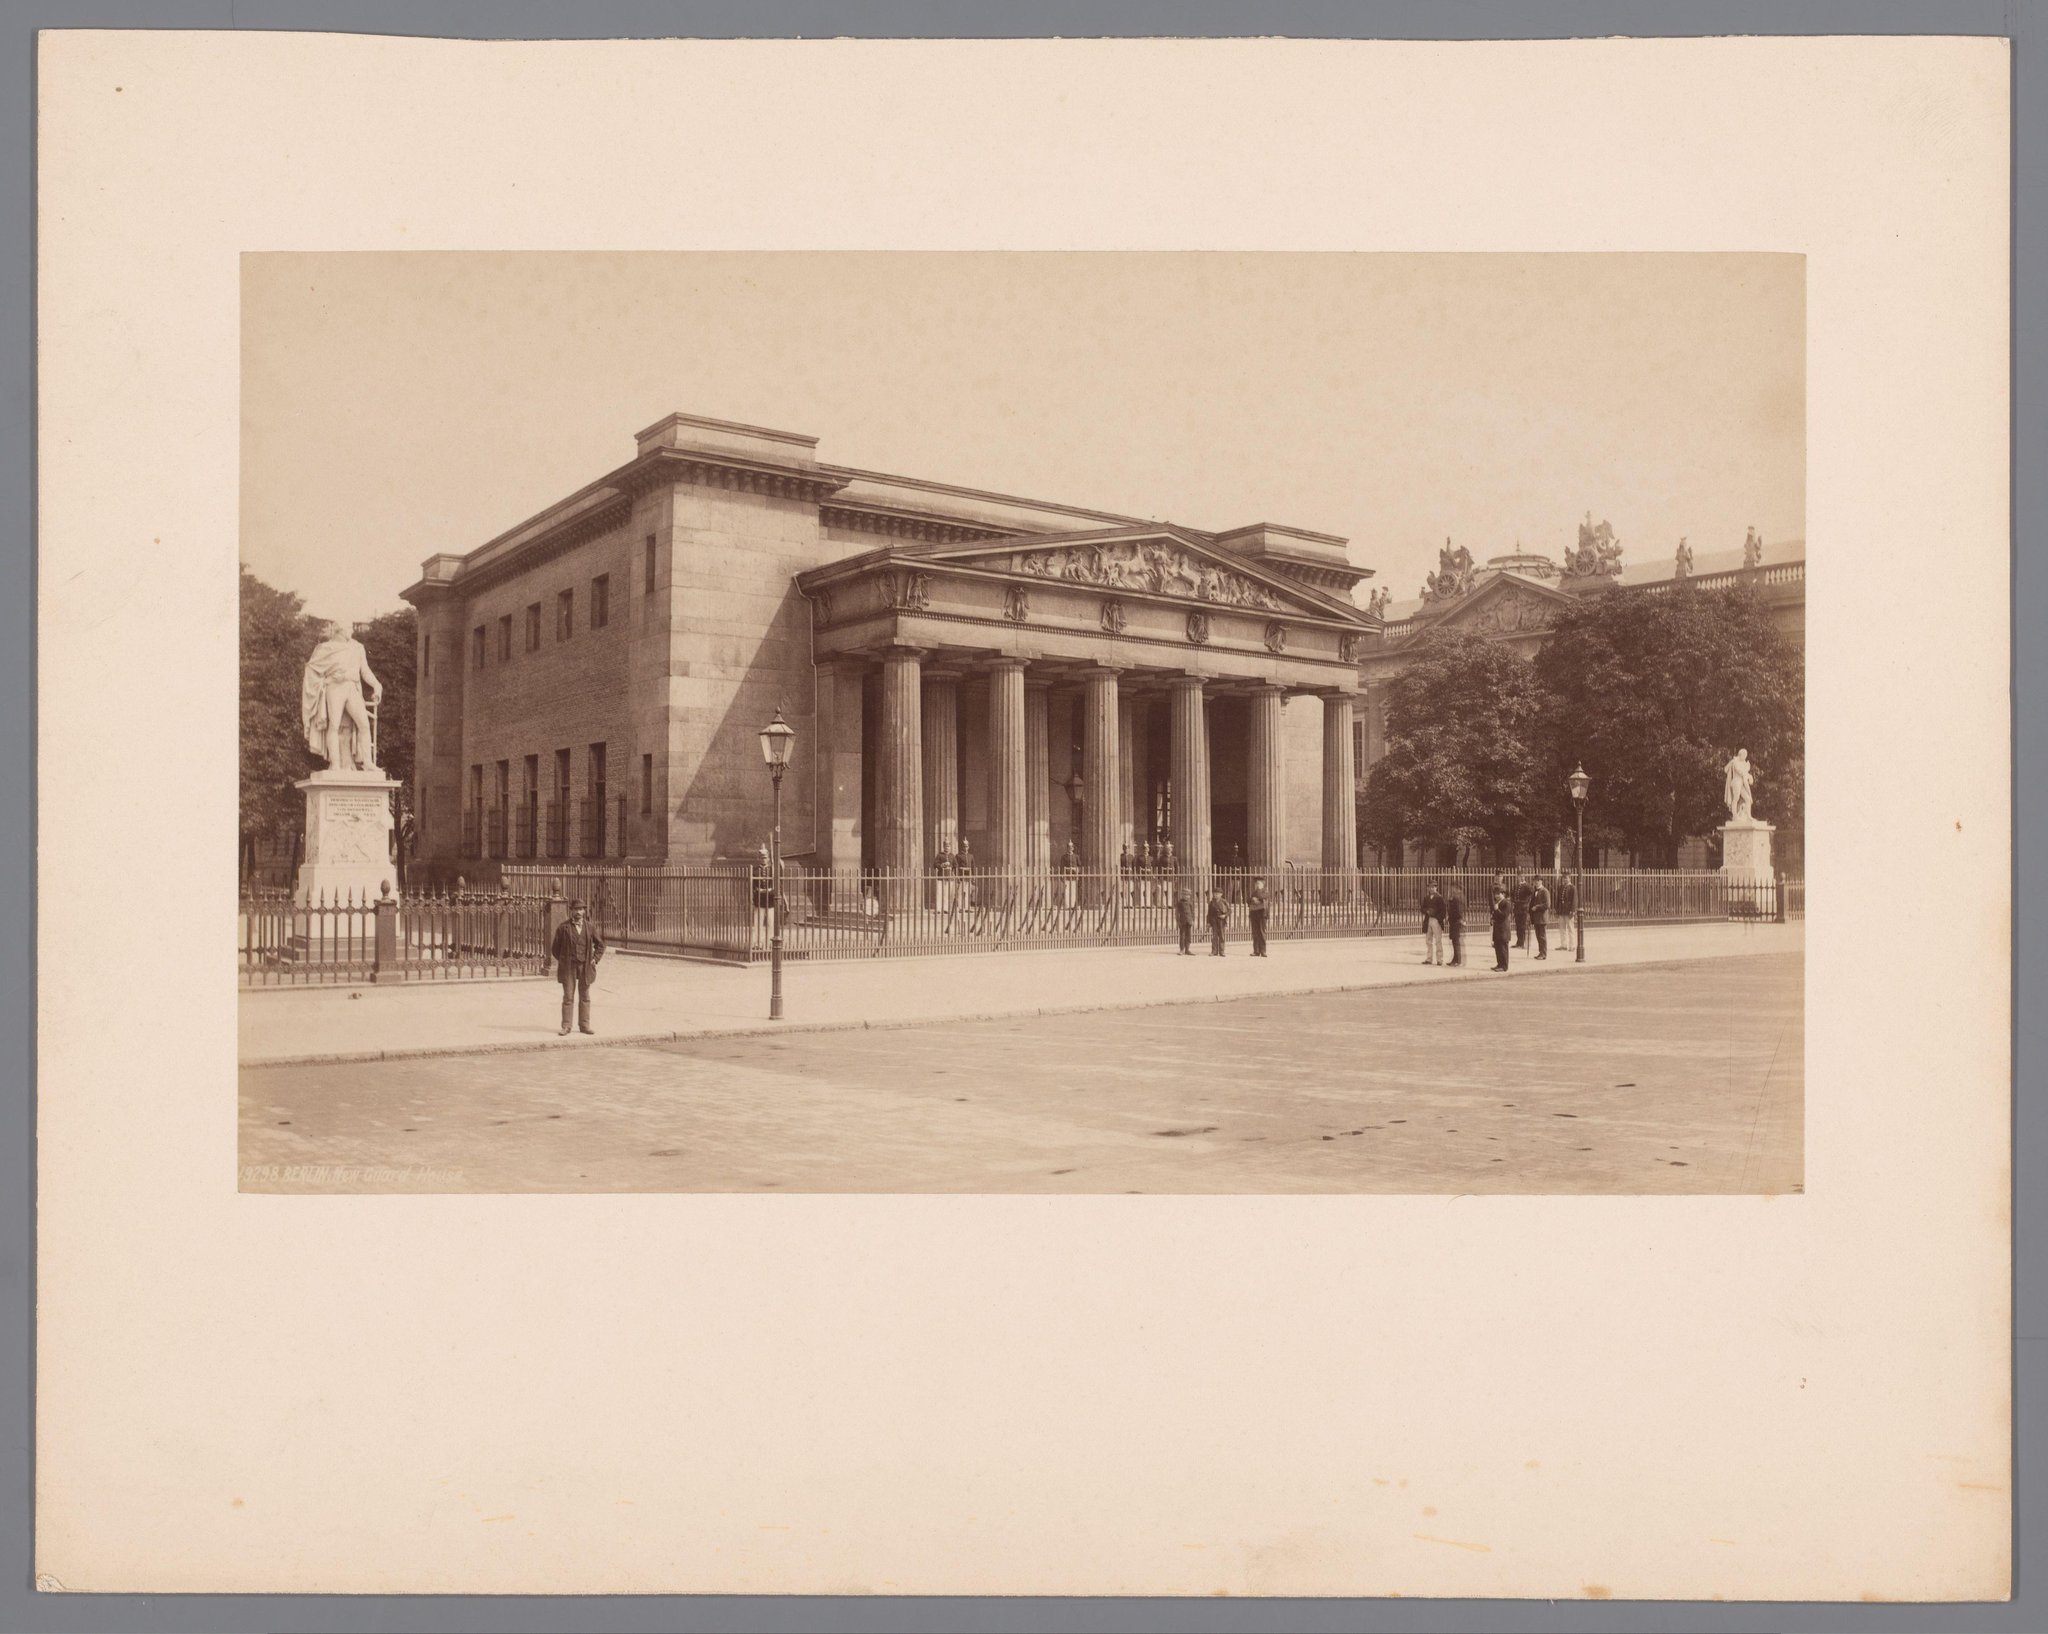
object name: photograph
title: Neue Wache, Berlijn, Duitsland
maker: Anonymous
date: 1880-1910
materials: cardboard, paper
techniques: albumen print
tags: berlin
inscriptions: caption: ‘19298 BERLIN, NEW GUARD HOUSE’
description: Neue Wache is een neoclassicistisch gebouw uit 1816 van de architect Karl Friedrich Schinkel. Het was tot 1931 in gebruik als een legerplaats voor de Pruissische troepen, sinds die tijd is het een oorlogsmonument.